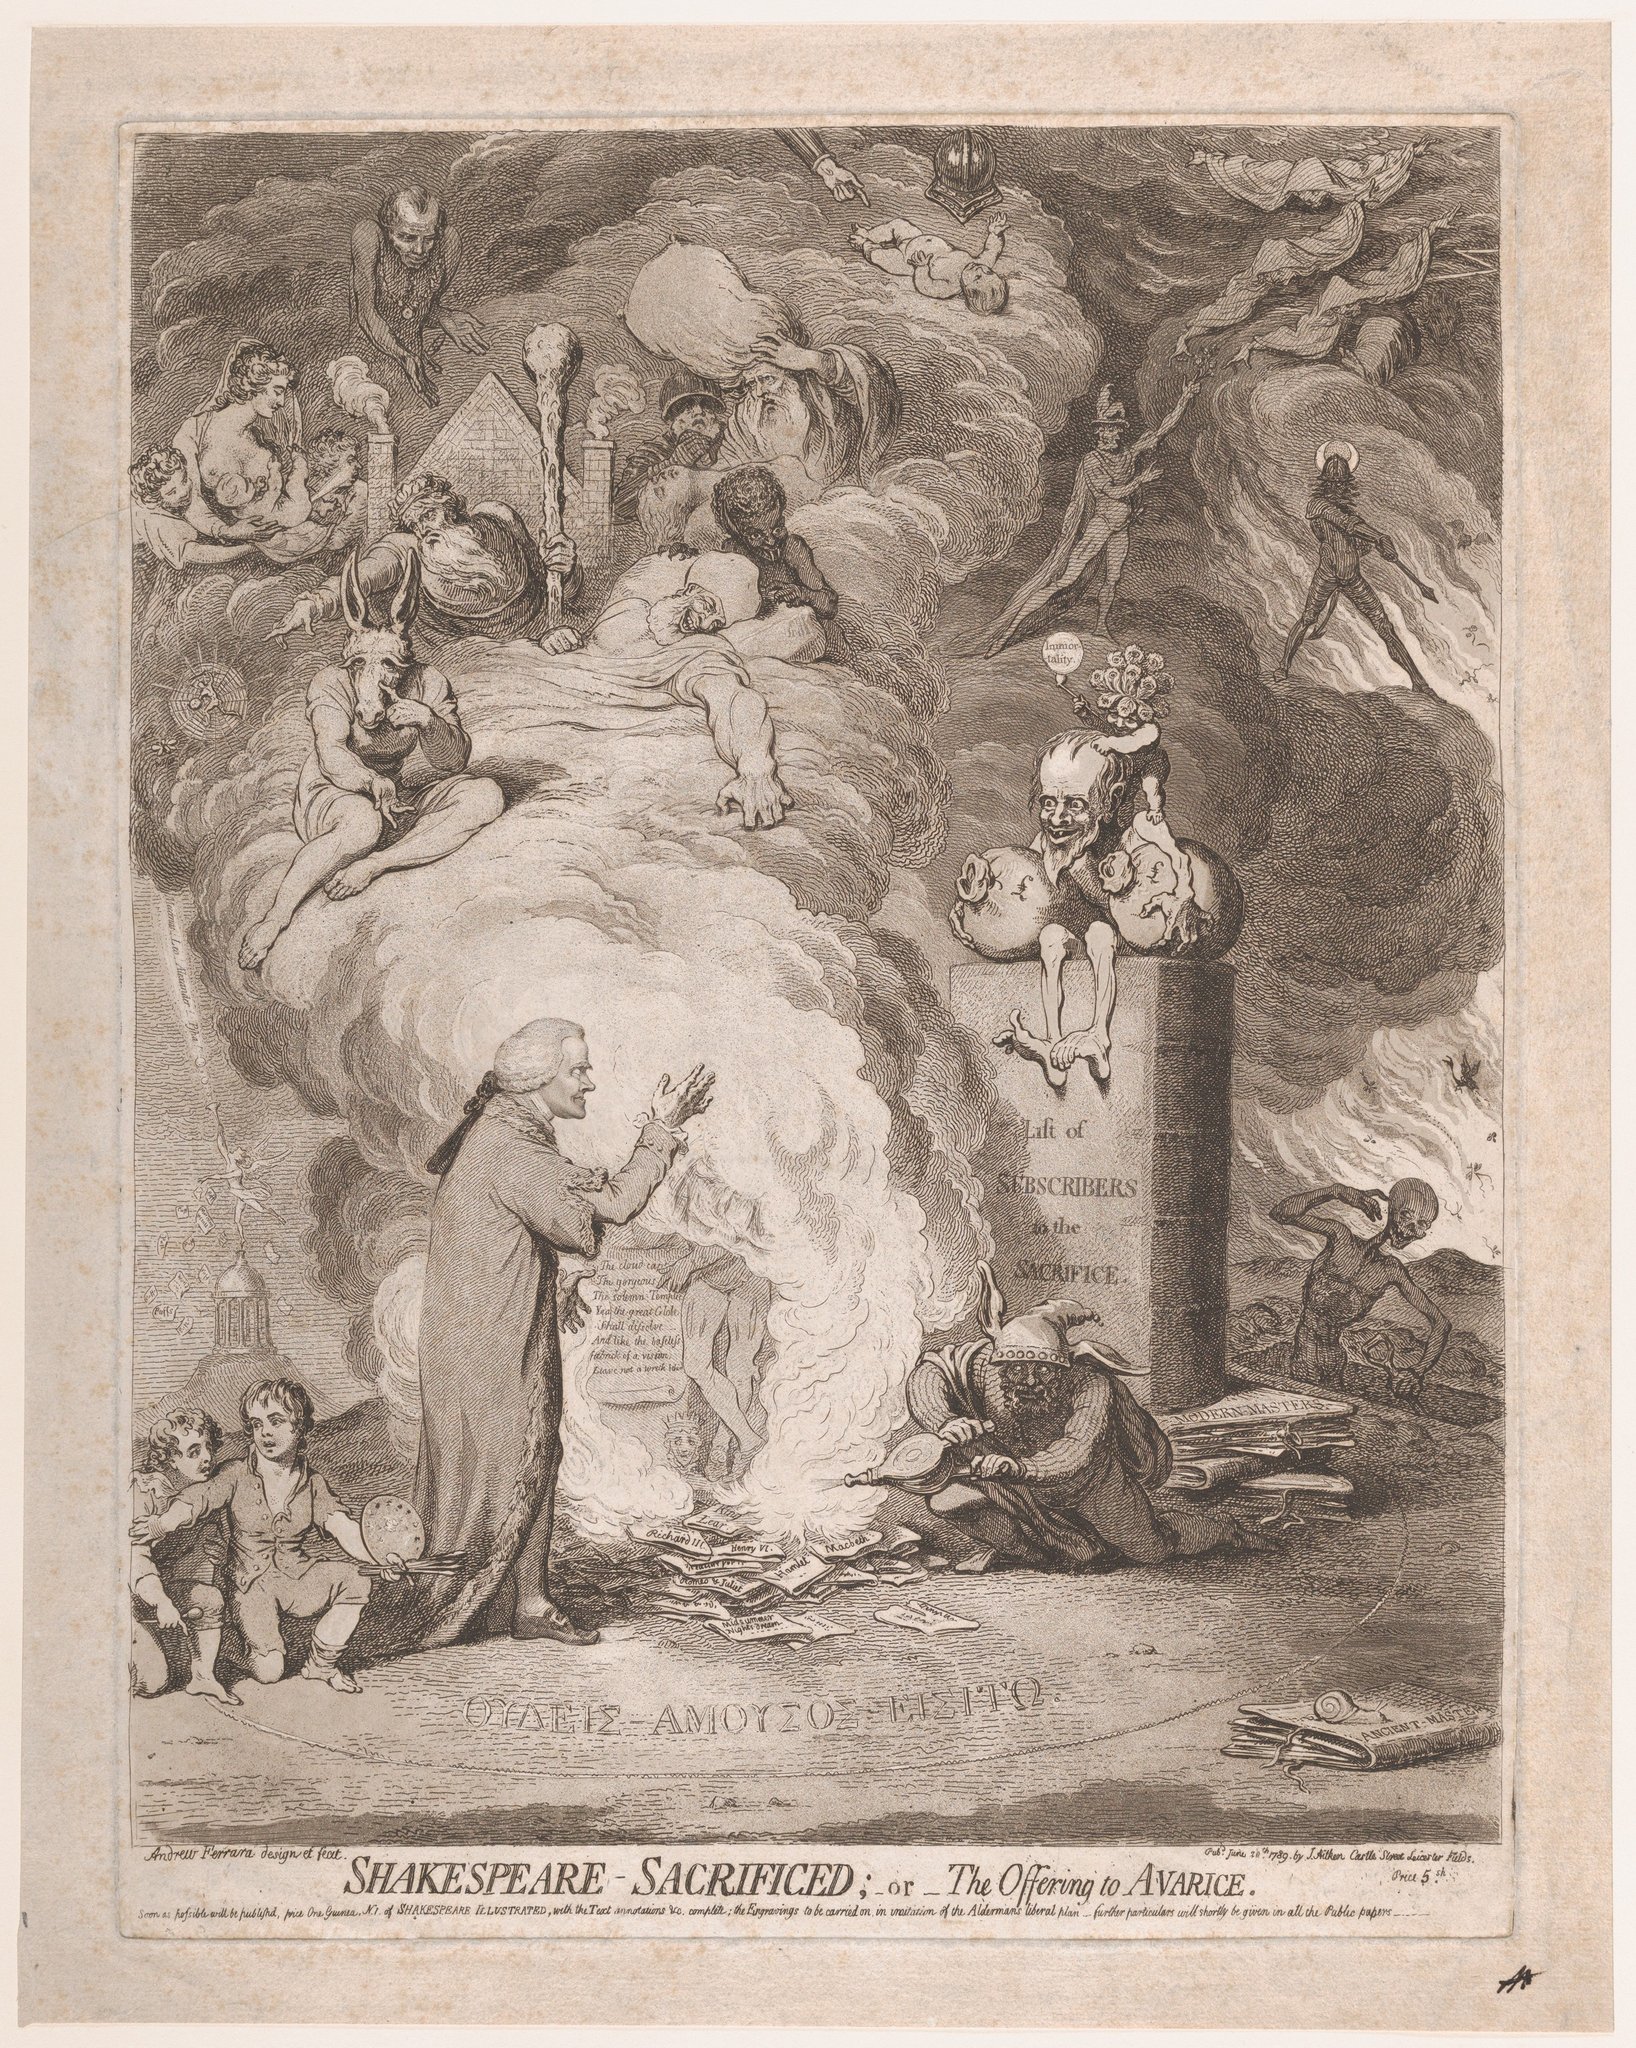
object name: print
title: Shakespeare – Sacrificed; or, The Offering to Avarice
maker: james gillray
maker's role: artist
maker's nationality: british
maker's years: 1756-1815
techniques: aquatint, etching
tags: satire,shakespeare